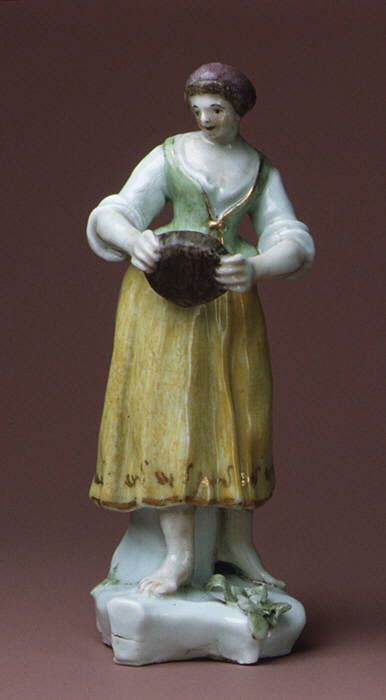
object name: figure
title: Girl with cheese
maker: capodimonte porcelain manufactory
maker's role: manufactory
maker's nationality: italian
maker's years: 1740-1759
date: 1755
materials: soft paste porcelain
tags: cheese,girls